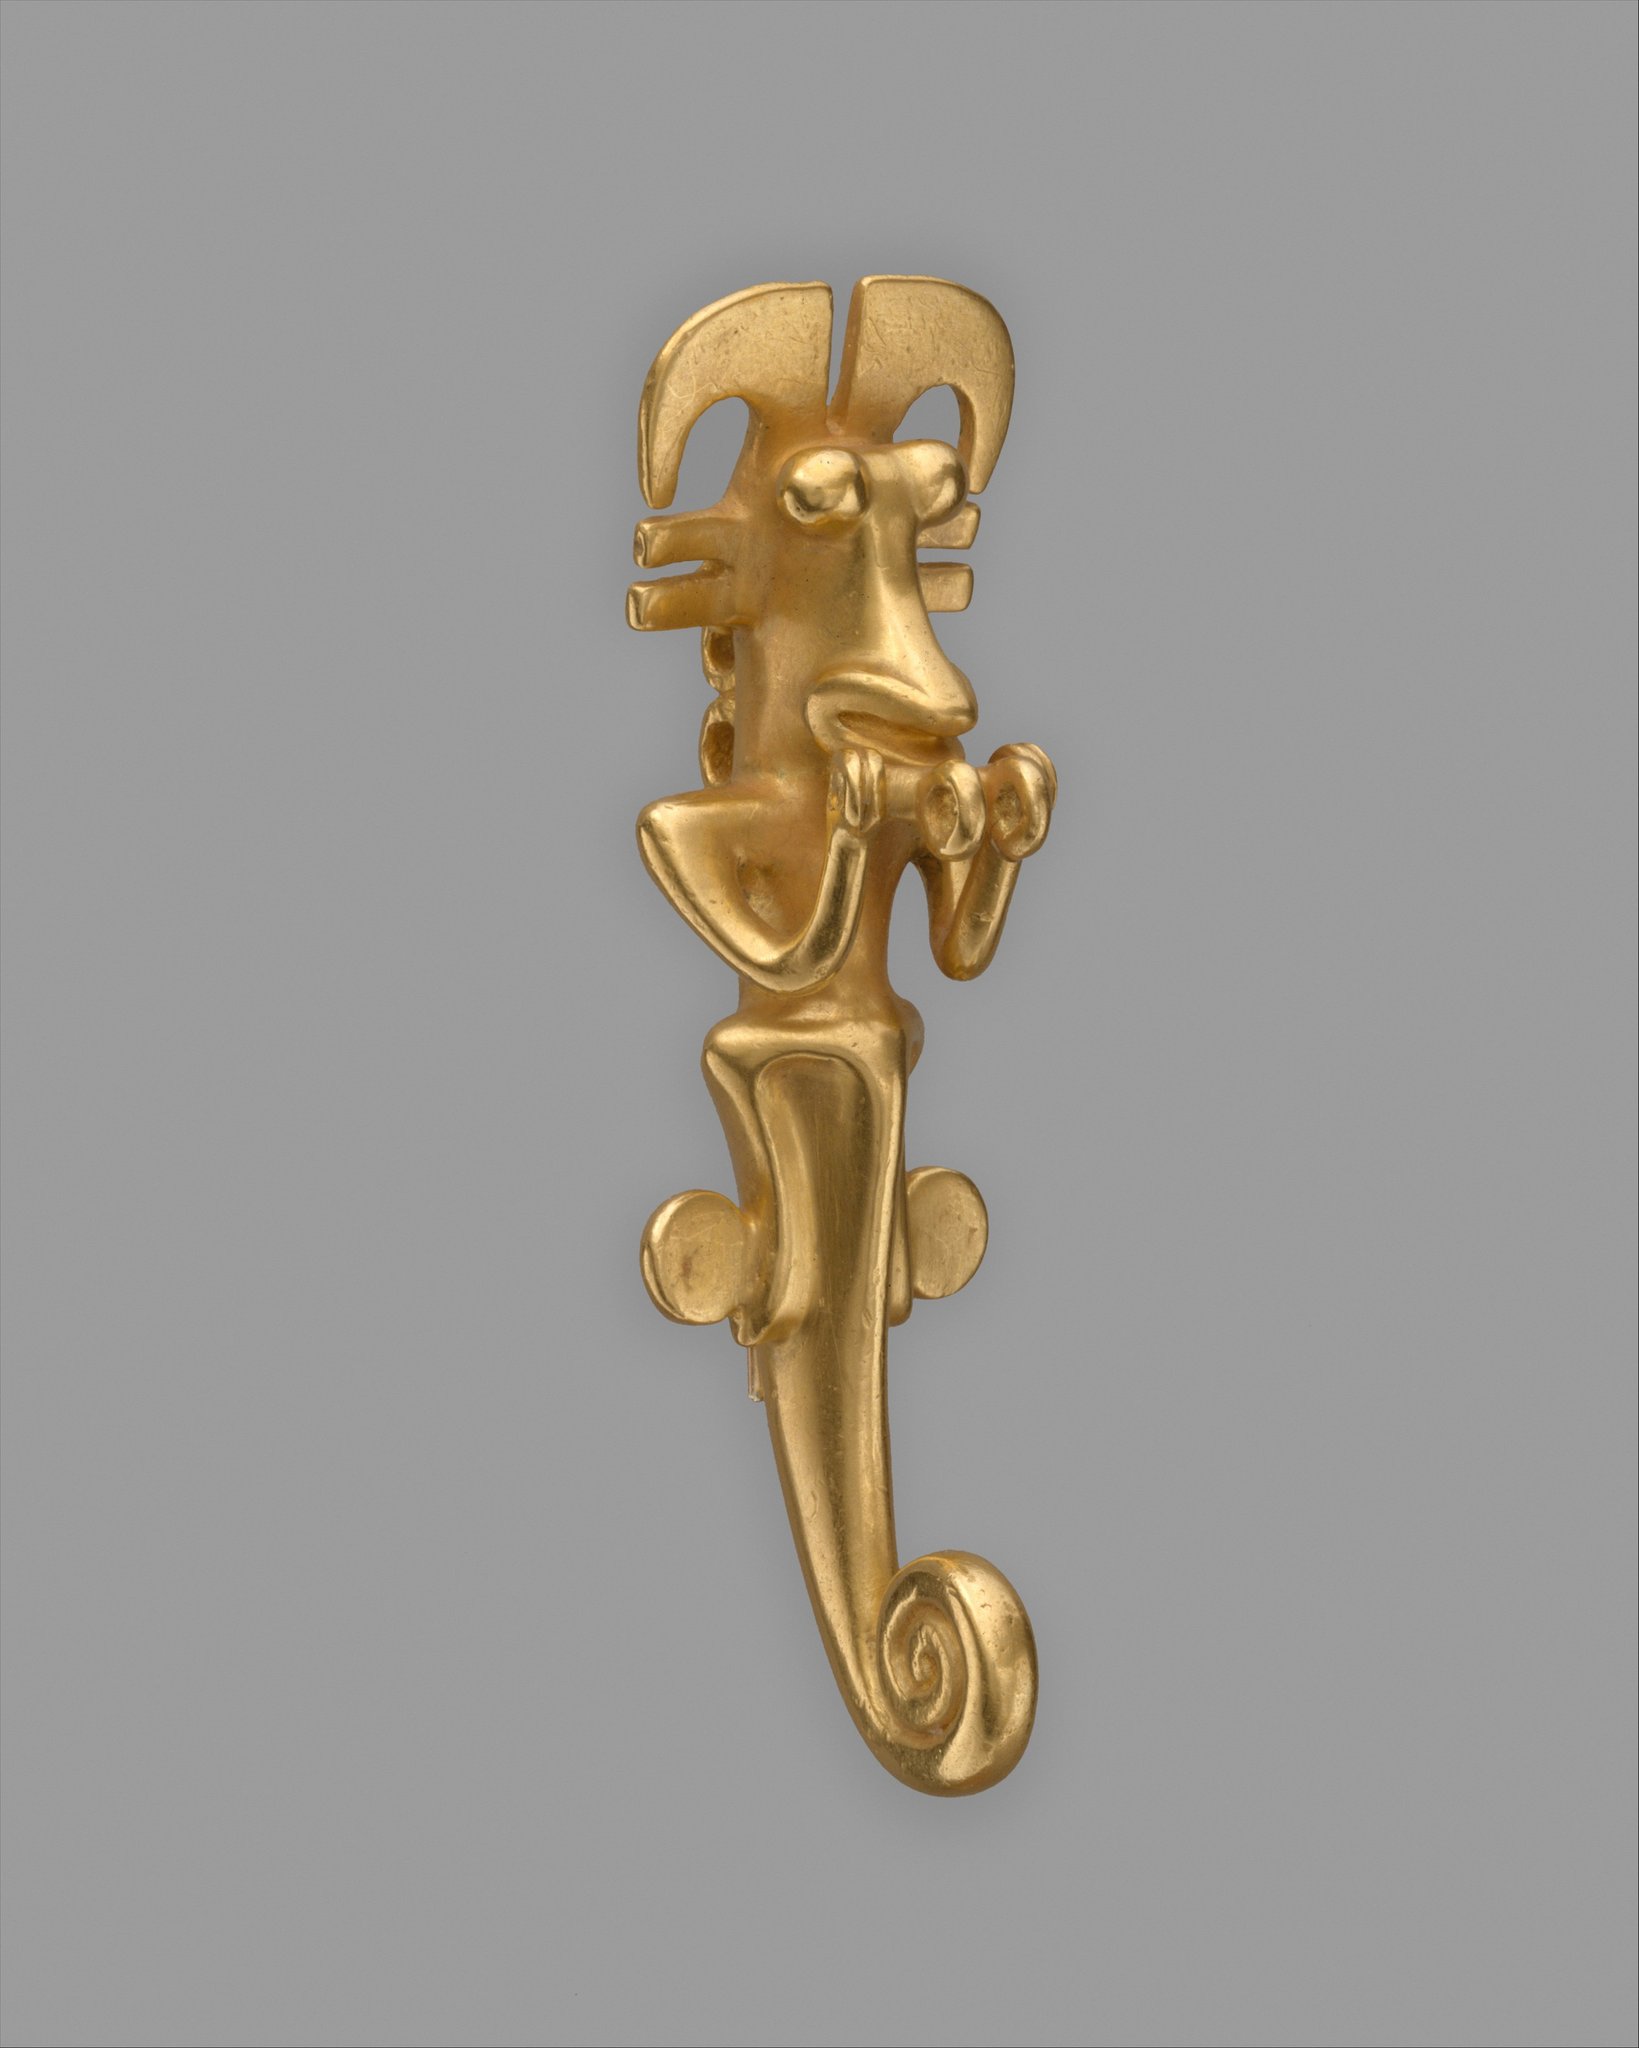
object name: pendant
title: Seahorse pendant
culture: international style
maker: international style artist(s)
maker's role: artist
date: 400-900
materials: gold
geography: panama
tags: animals